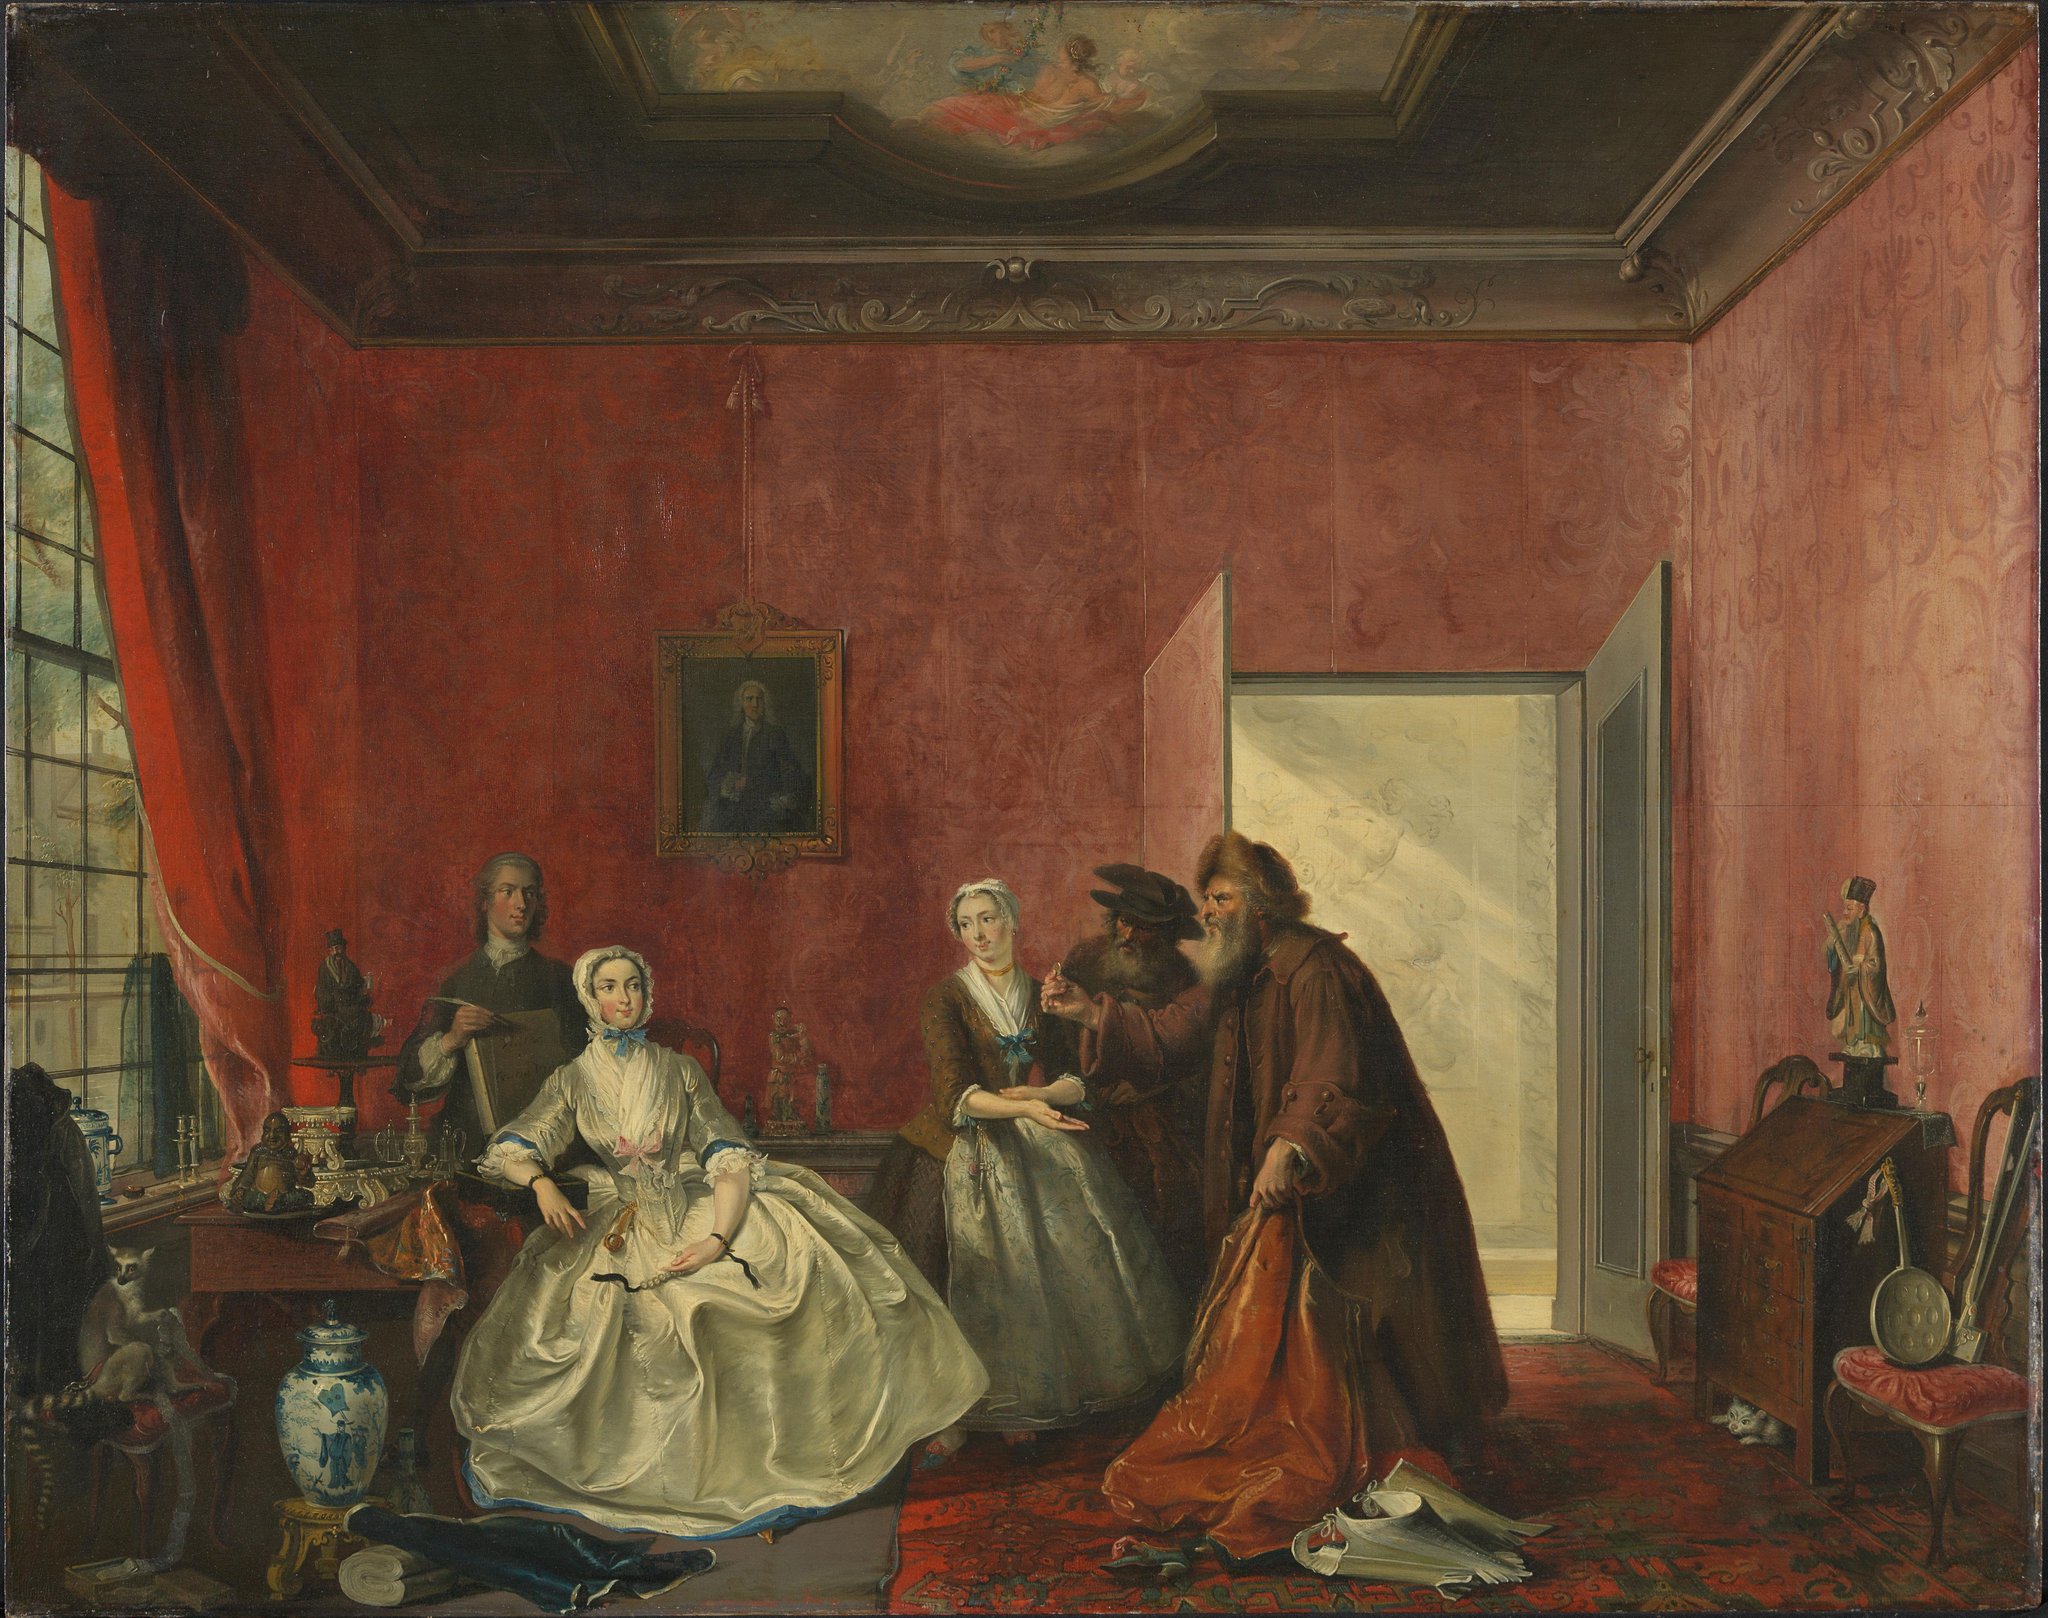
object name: painting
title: Johanna and the Jewish Merchants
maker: cornelis troost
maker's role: draughtsman, painter, print maker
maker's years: 1696-1750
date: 1741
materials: oil, panel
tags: decorations (interior of the house), squandering, extravagance, prodigality, waste; 'prodigalità' (ripa) (+ 'exemplum', representation of exemplary (historical) event), collecting (leisure time activity), anti-semitism, coin, comedy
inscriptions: signature and date: ‘C. Troost 1741’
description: Troost depicted a scene from the popular farce The Spendthrift or the Wasteful Woman. The central character, Johanna, wastes her new expensive finery on two Polish-Jewish traders, portrayed in a stereotypical manner. In reality, they are Johanna’s father and husband, who have disguised themselves in order to expose her. Perched on the chair at the left, amidst a variety of Chinese valuables, is a ring-tailed lemur from Madagascar.